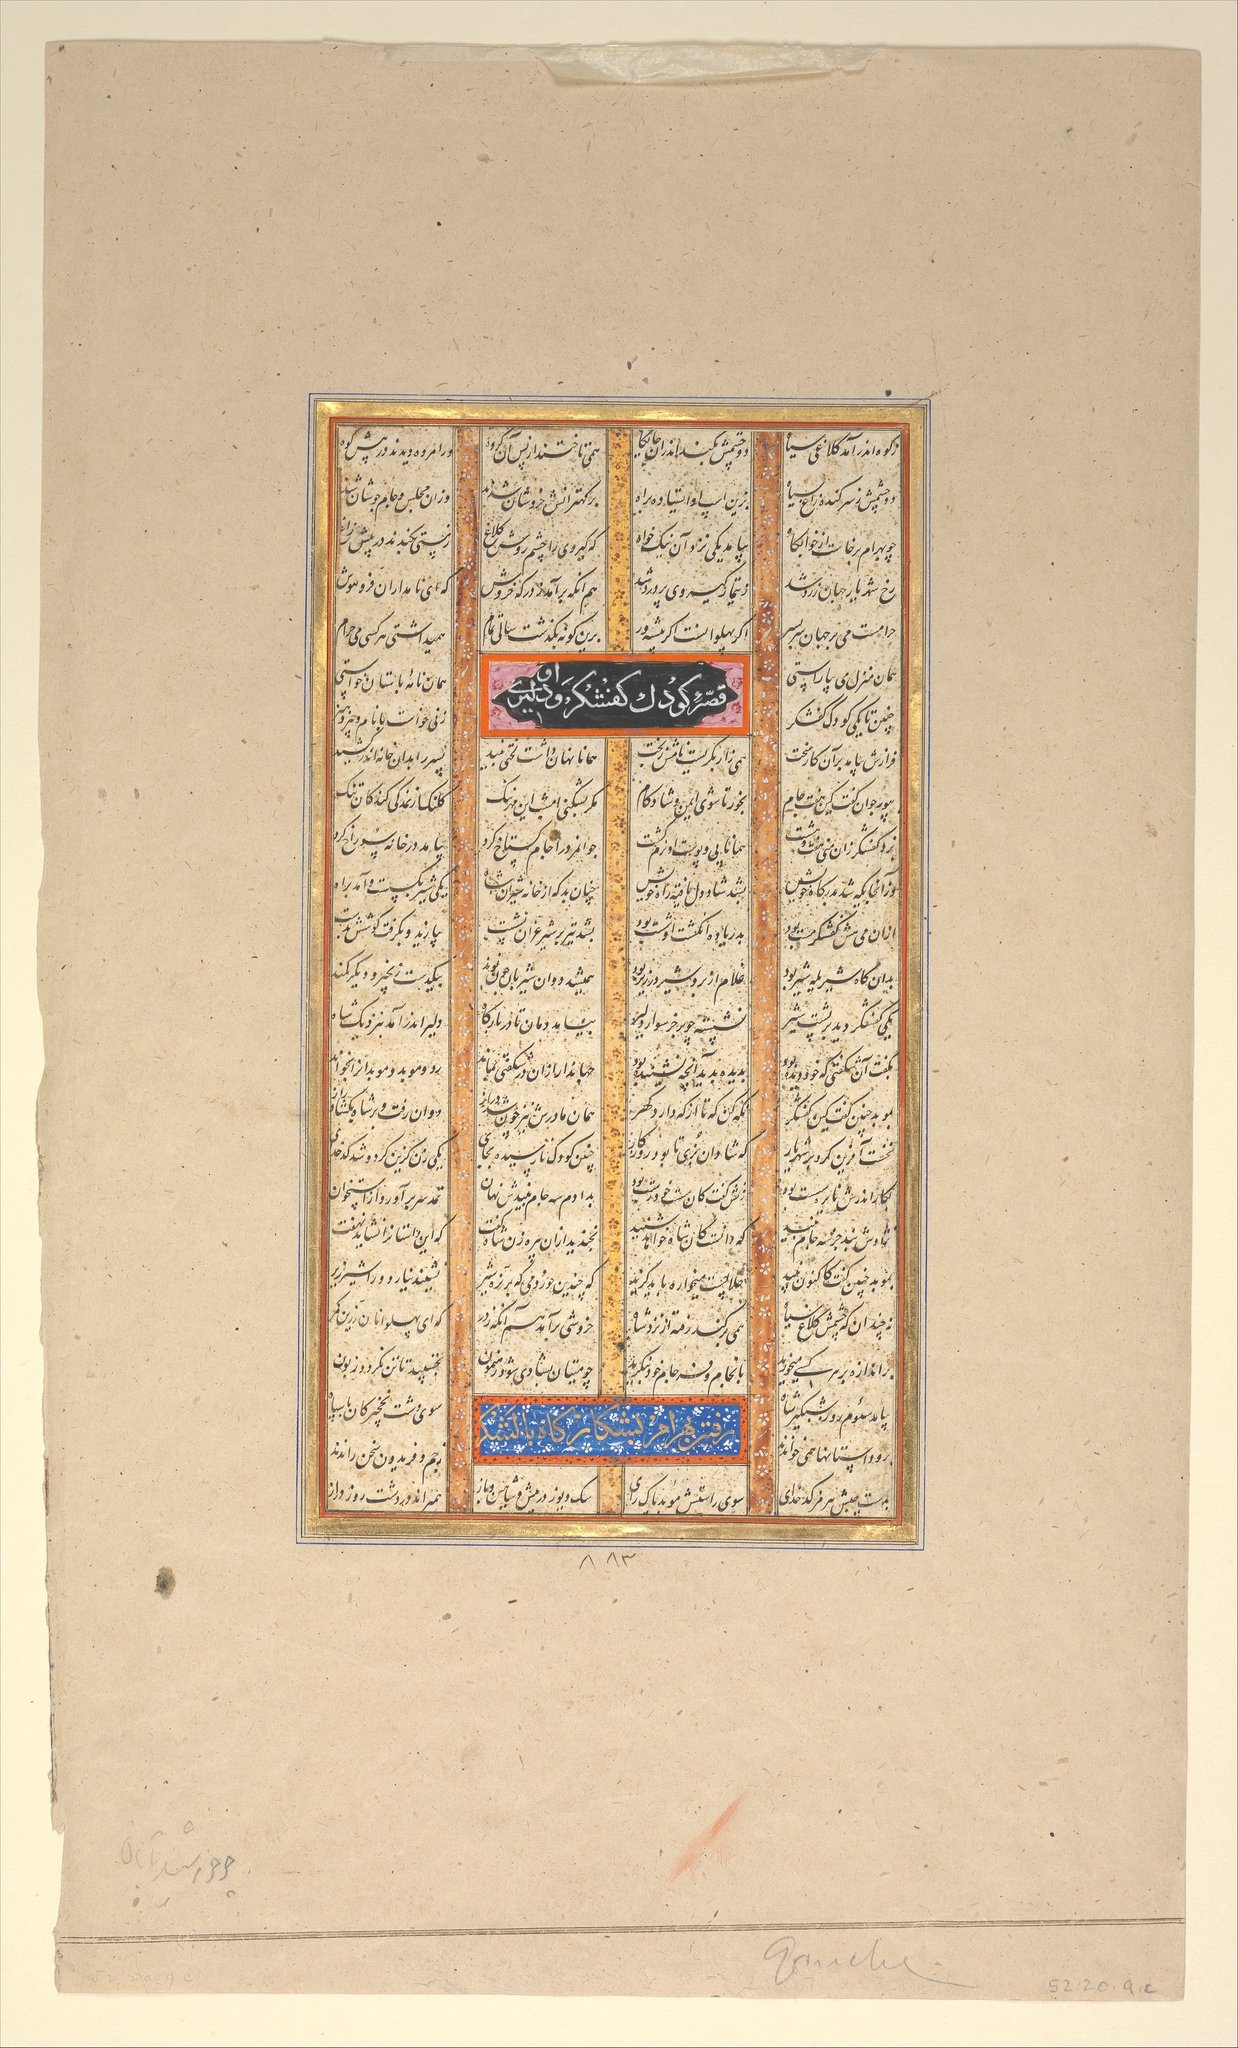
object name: folio from an illustrated manuscript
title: Page of Calligraphy from a Shahnama (Book of Kings)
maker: muhammad ibn taj al-din haidar muzahhib shirazi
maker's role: calligrapher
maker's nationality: iranian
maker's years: 1535-1605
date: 1562-1583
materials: gold, ink, paper, watercolor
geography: iran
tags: calligraphy